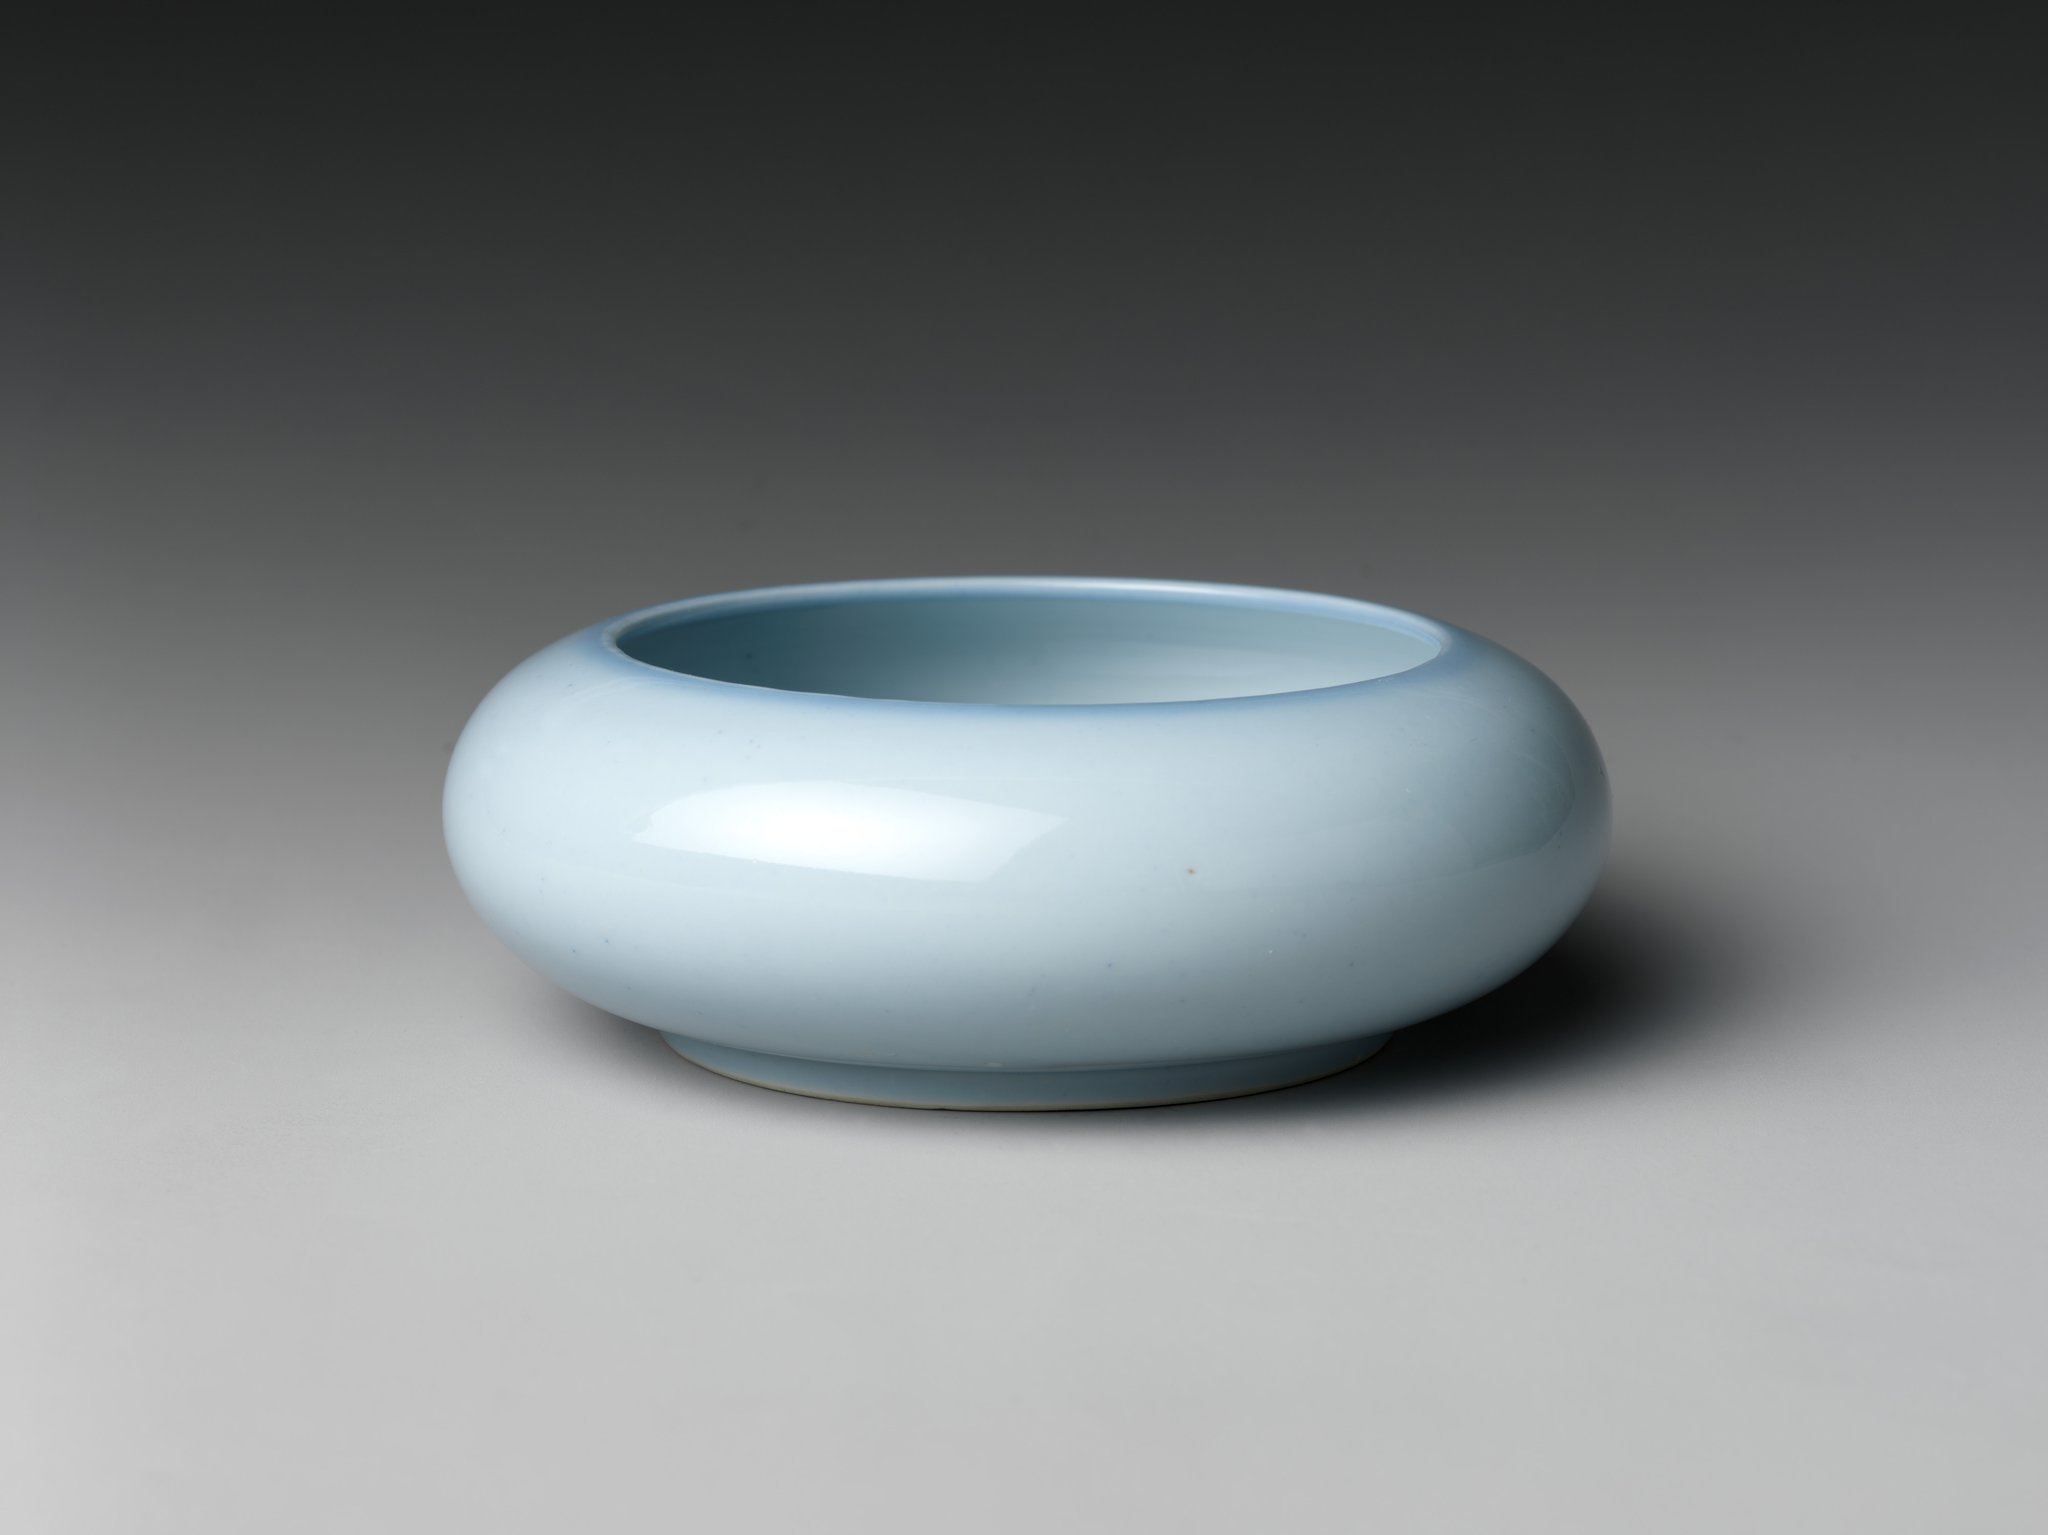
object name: brush washer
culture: chinese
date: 1713-1722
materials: glaze, porcelain